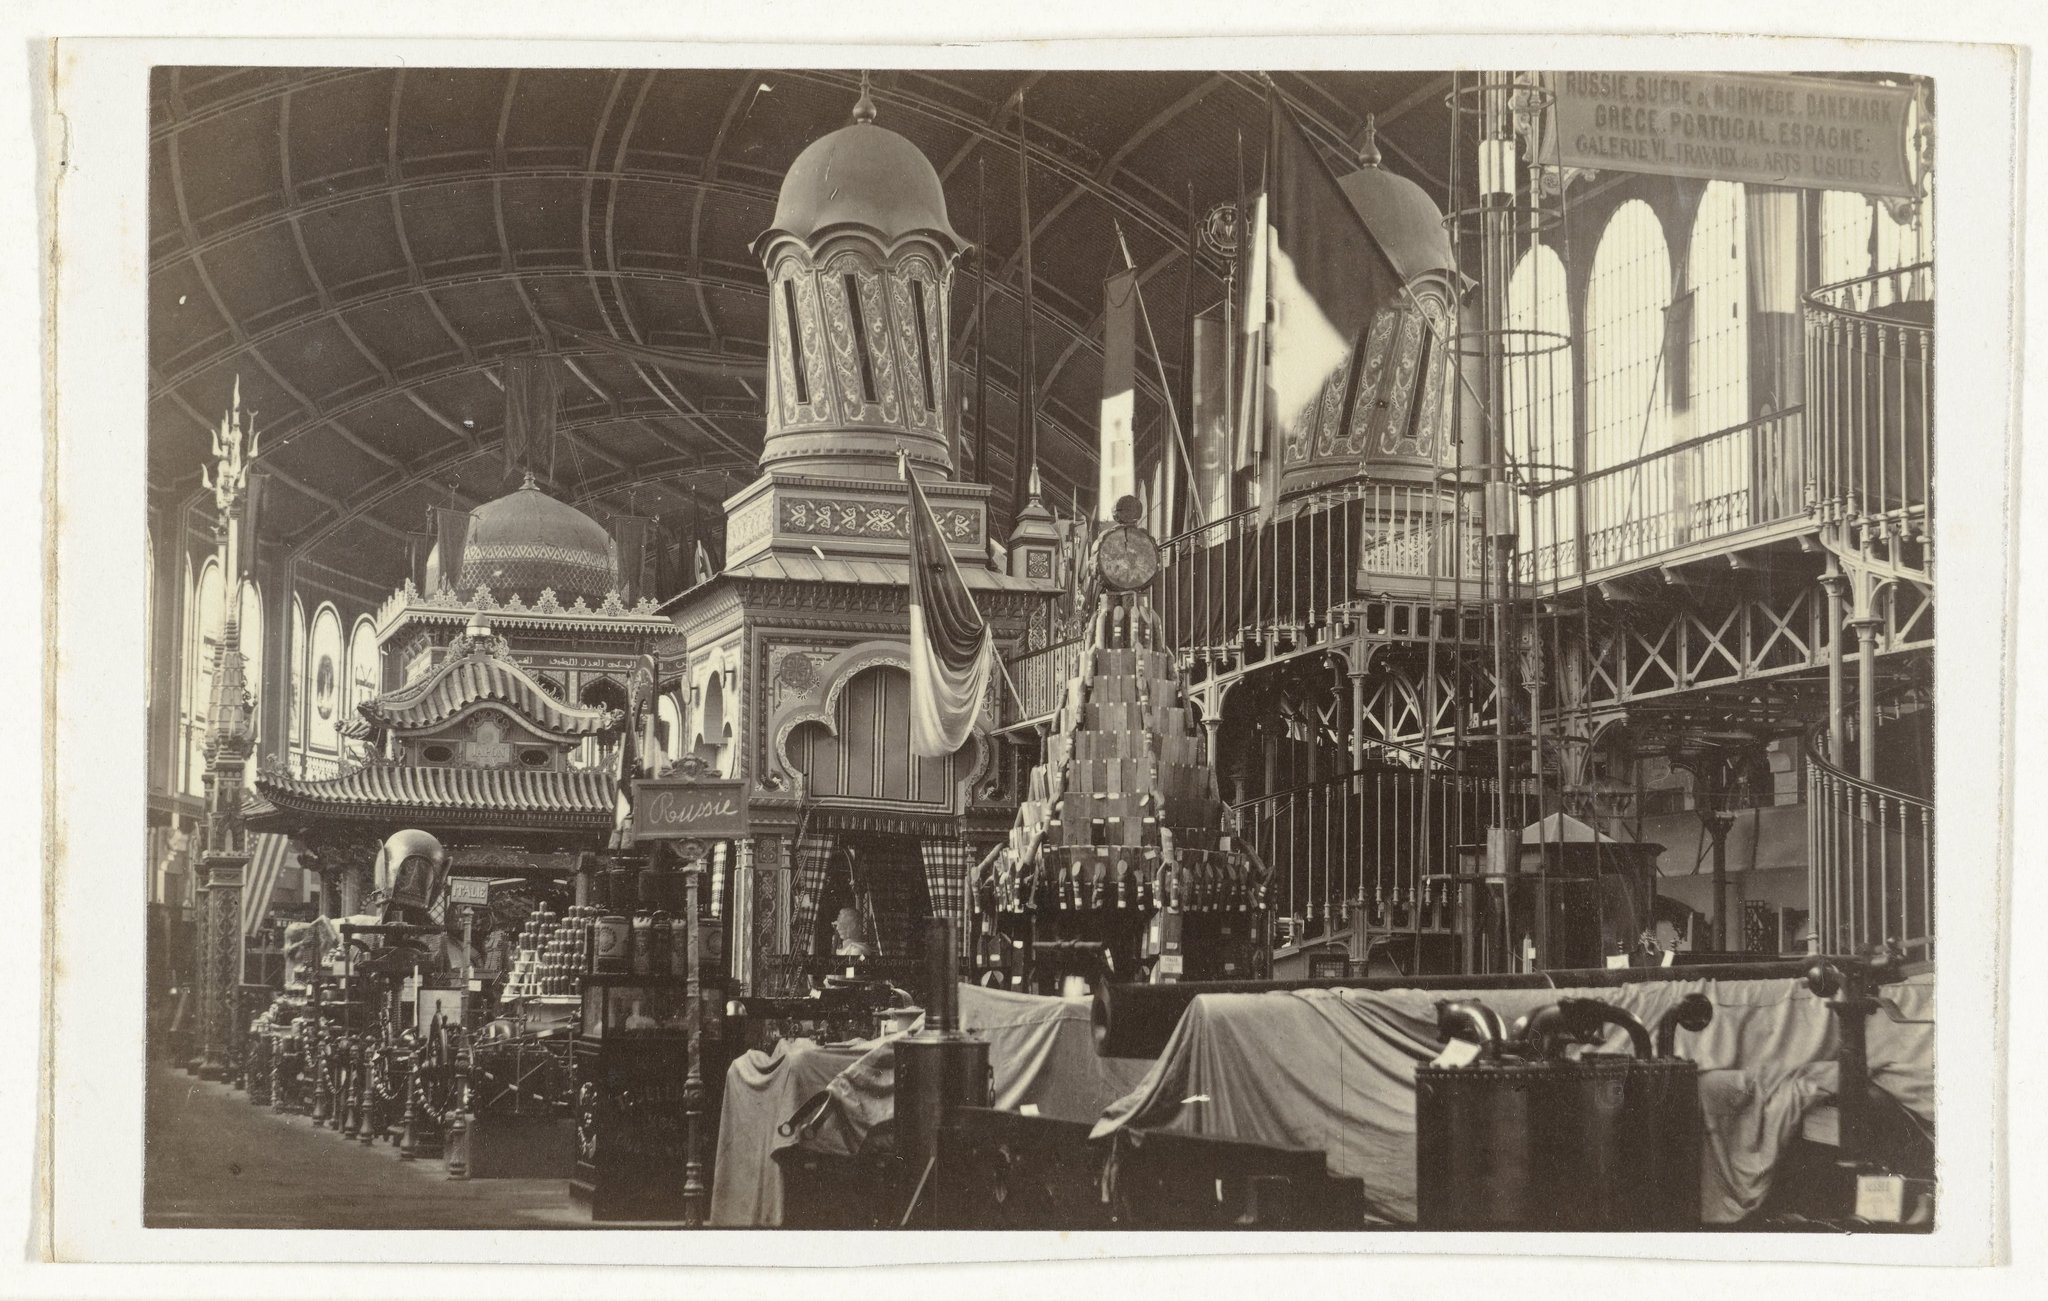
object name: photograph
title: Galerie des Machines op de Wereldtentoonstelling van 1867 in Parijs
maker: pierre petit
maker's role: fotograaf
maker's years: 1832-1909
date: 1867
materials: cardboard, paper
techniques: albumen print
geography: paris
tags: world fair, world exhibition, paris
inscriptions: inscription: ‘Exp 1867/ Galerie des Machines/ 120€’